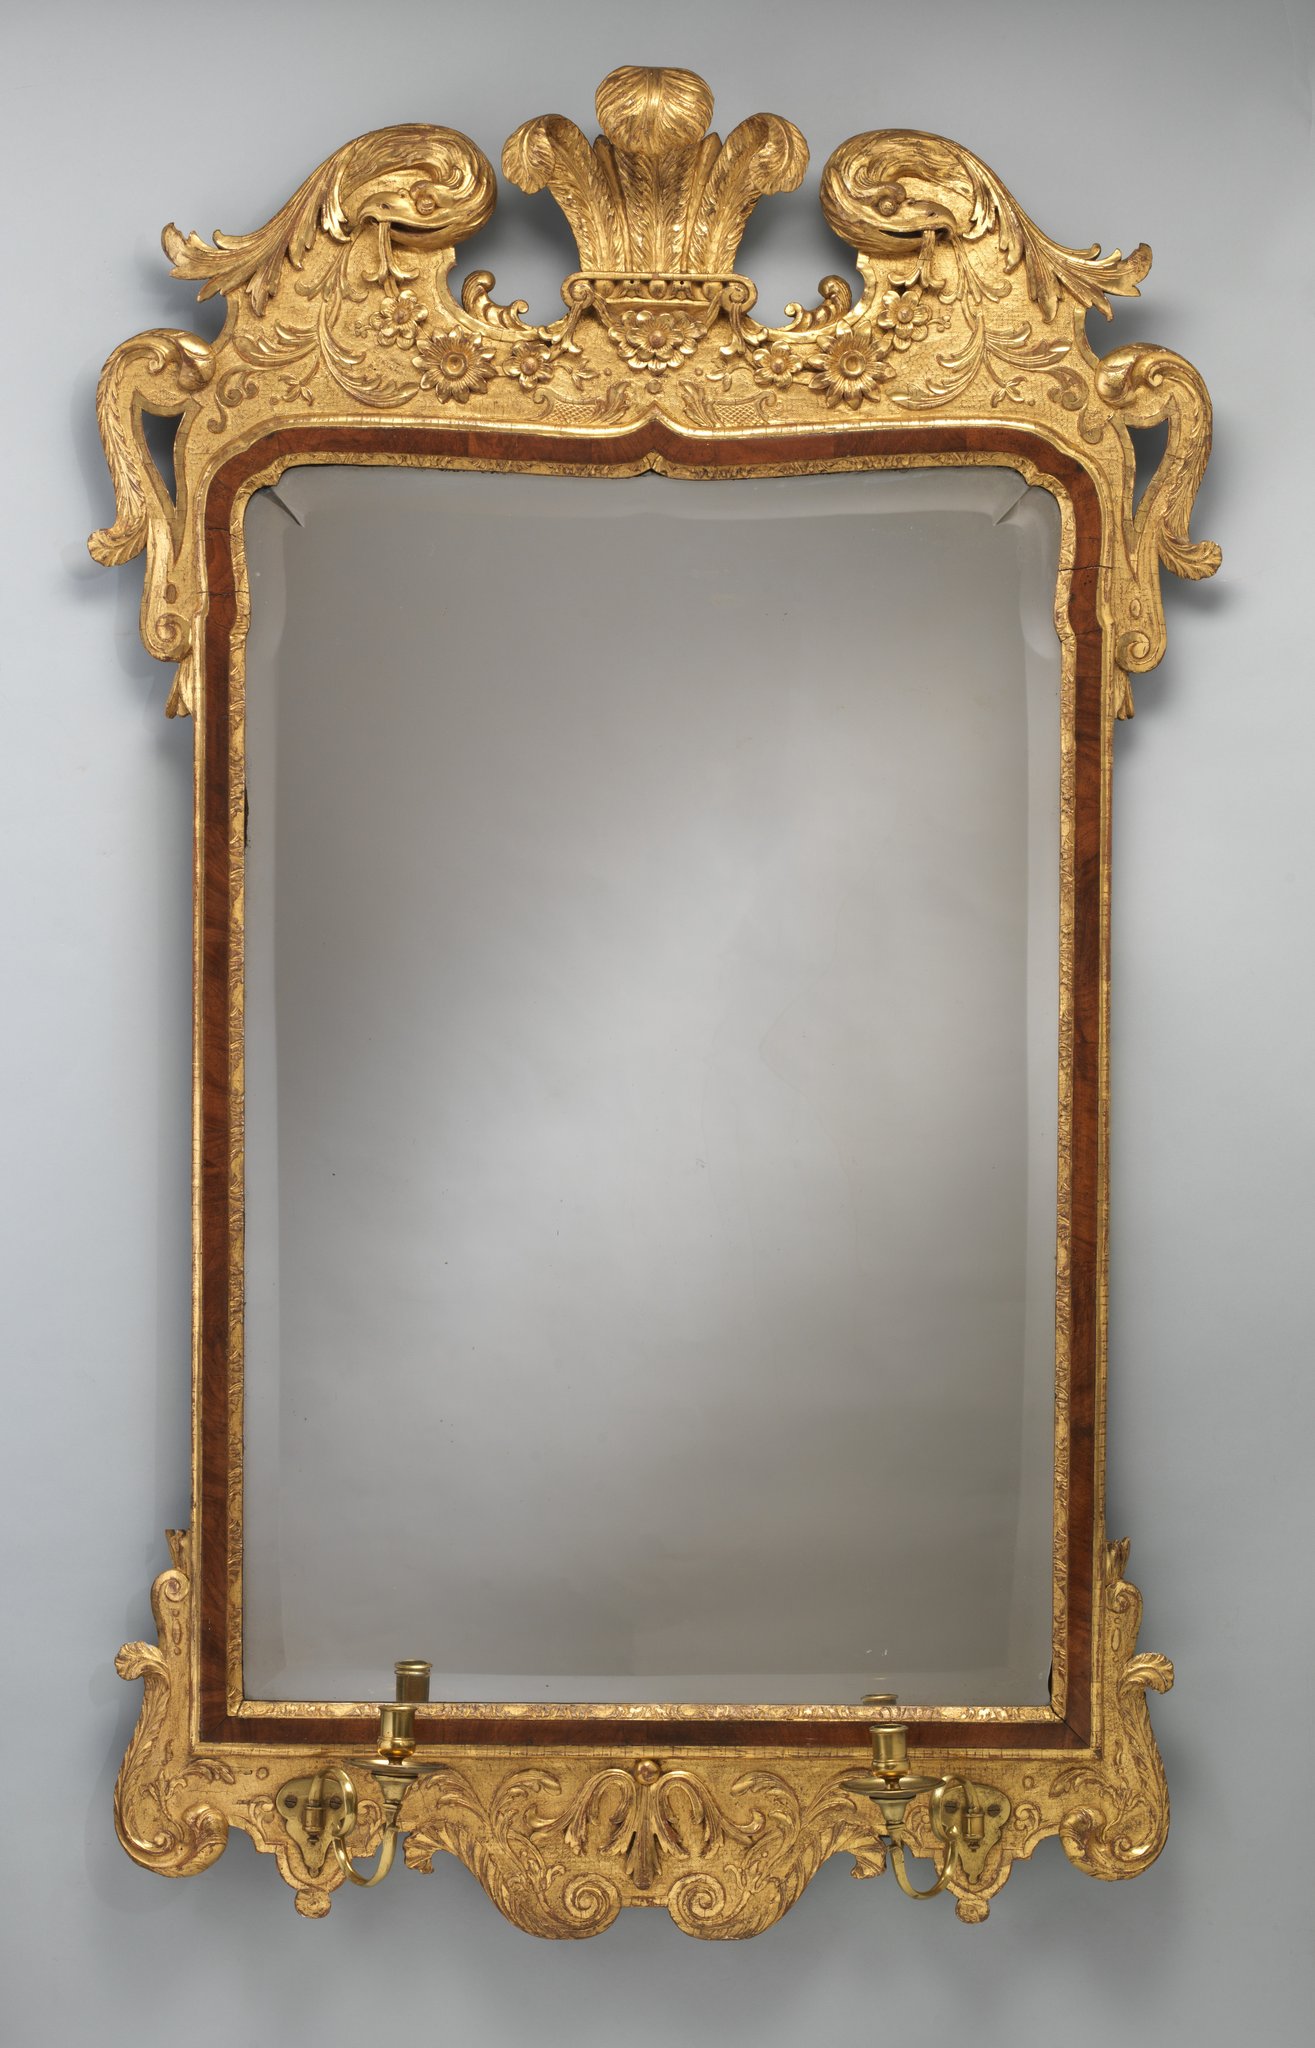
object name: mirror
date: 1720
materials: brass, gesso, gilt, glass, wood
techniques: veneering